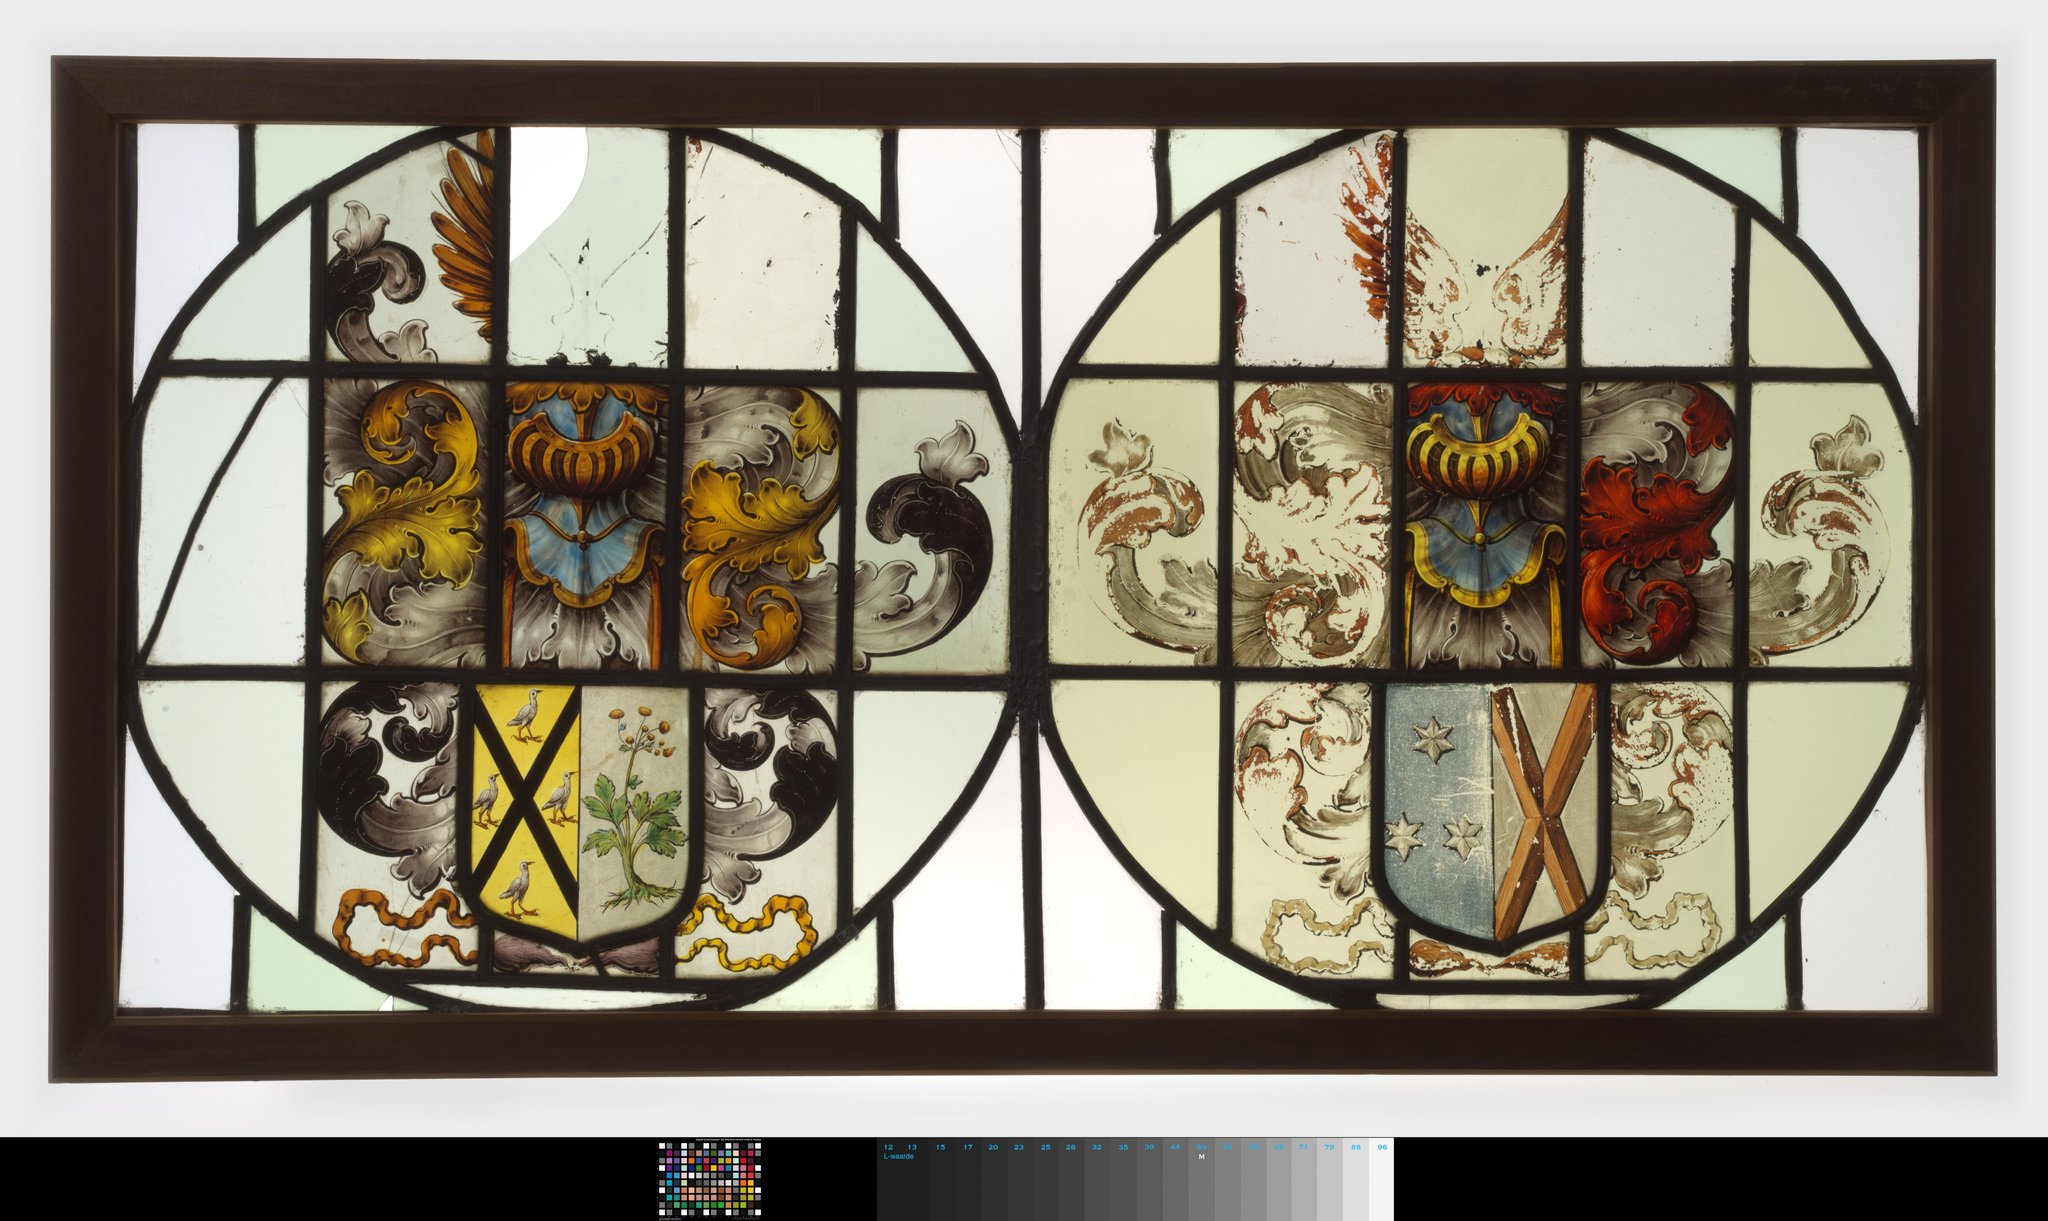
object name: light window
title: Ruit met in het wapenschild onder meer vier vogels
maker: Anonymous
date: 1650-1700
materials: glass, lead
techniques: leading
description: Ronde wapenruit met in het wapenschild een plant, vier gekleurde vogels en een zwart kruis op goud.